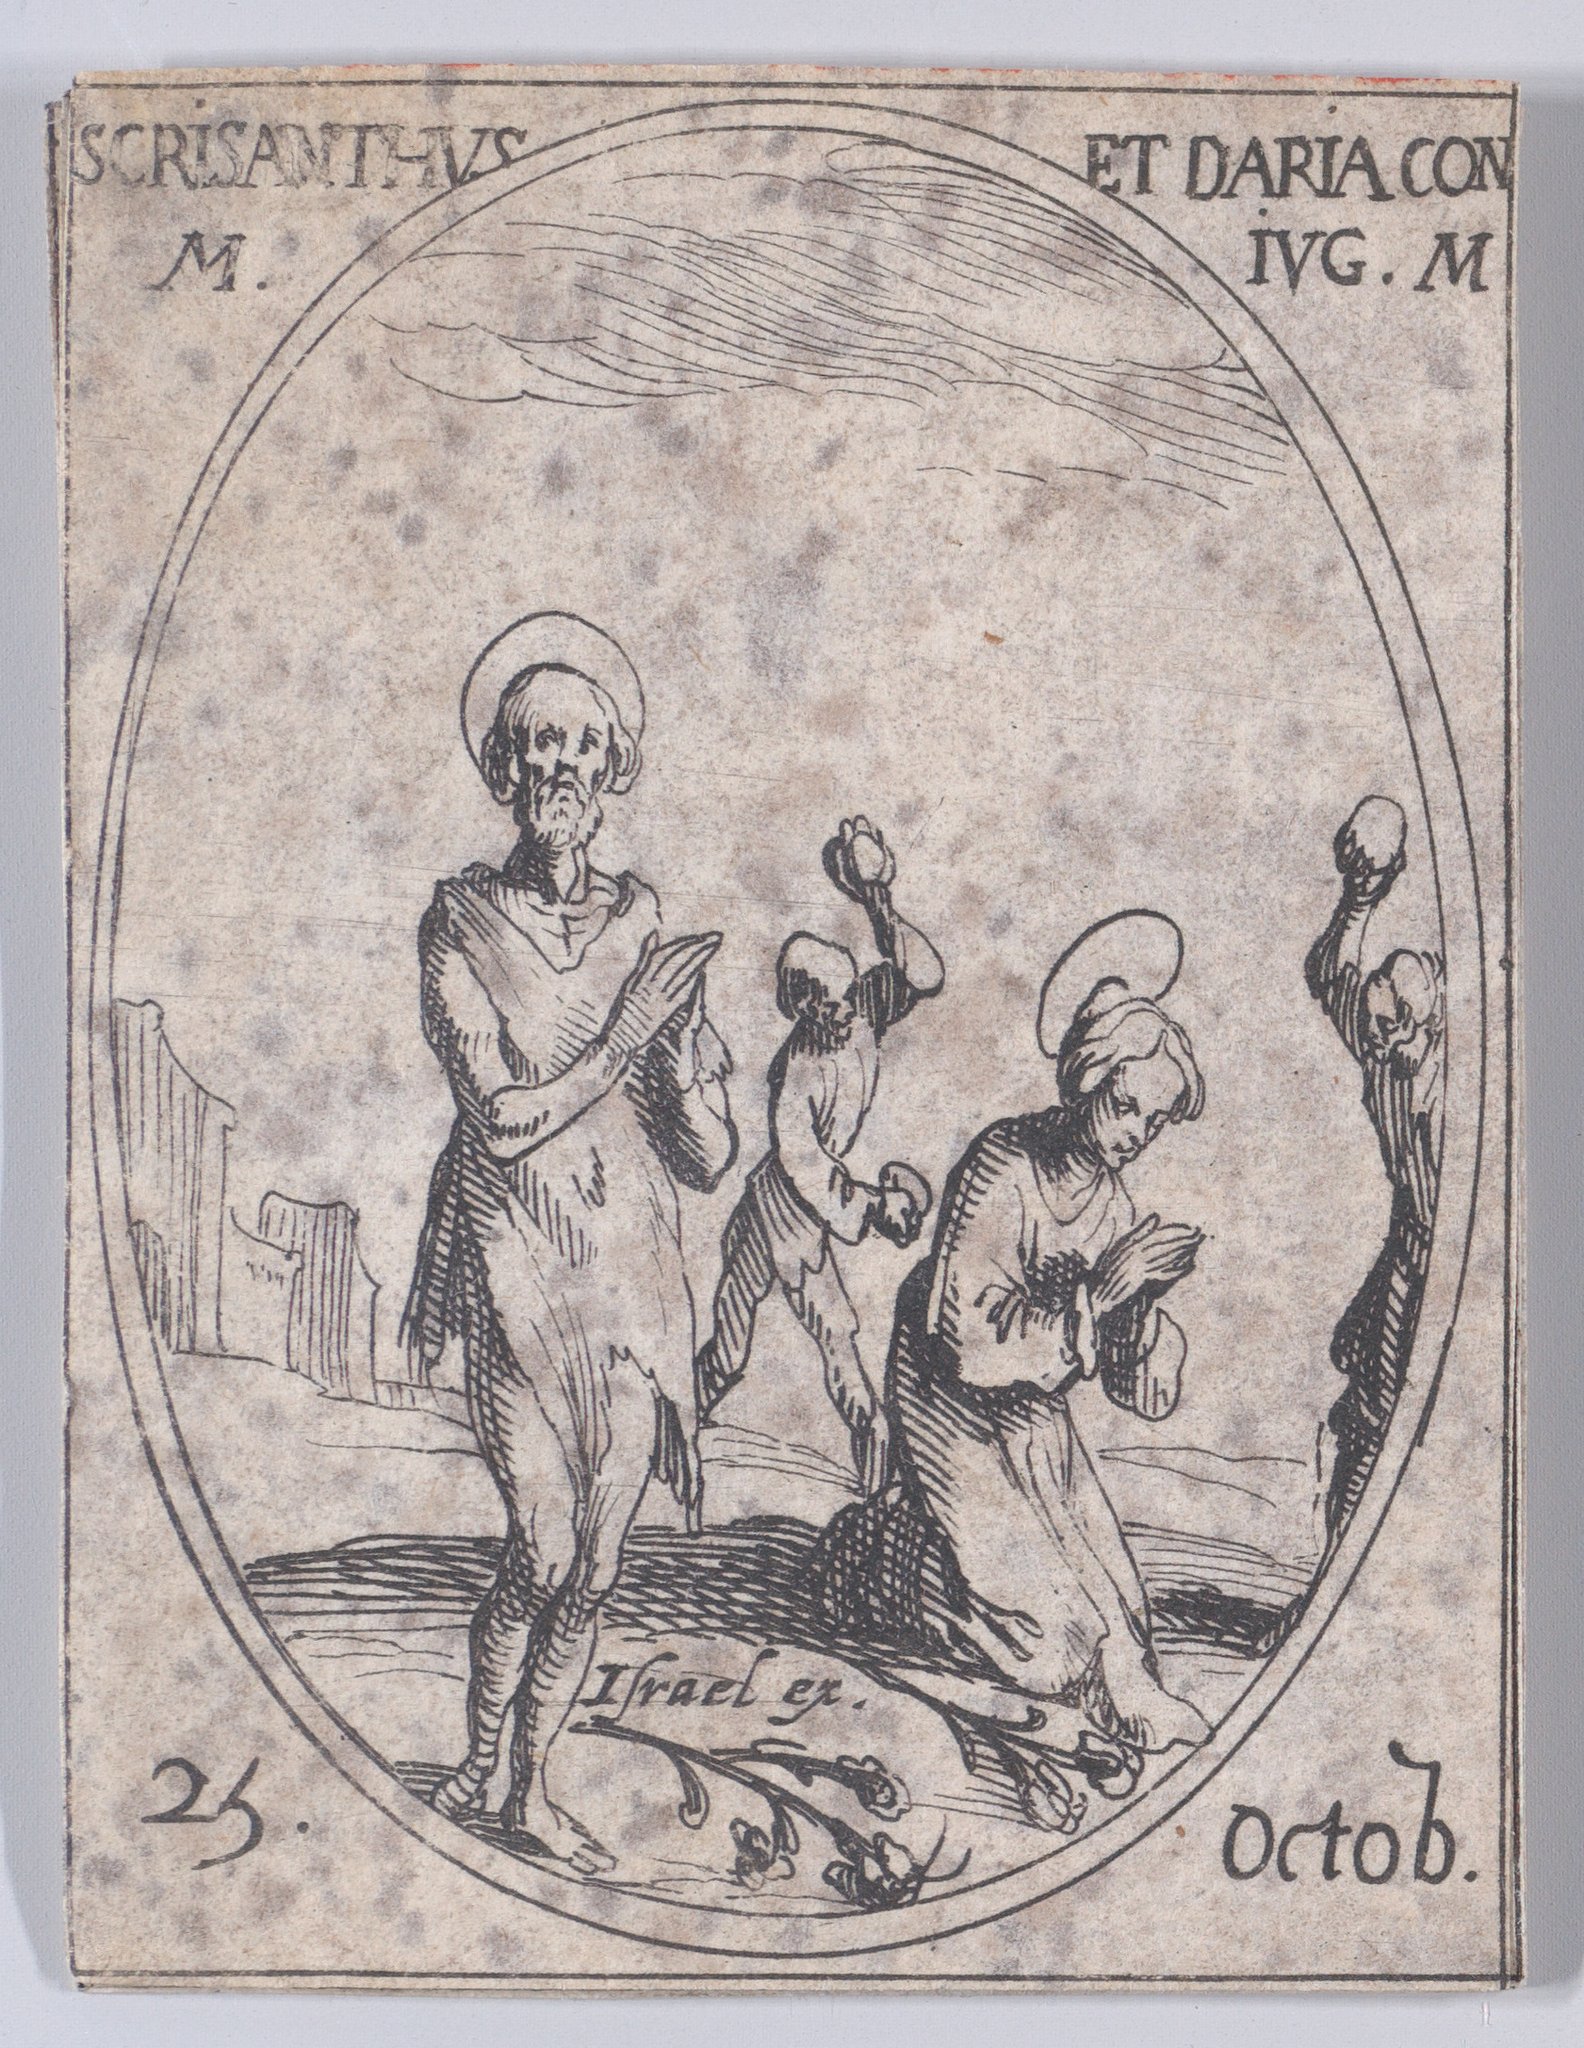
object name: print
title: S. Chrisante et Ste. Darie, Sa Femme (St. Chrysanthus and St. Daria, His Wife), October 25th, from "Les Images De Tous Les Saincts et Saintes de L'Année" (Images of All of the Saints and Religious Events of the Year)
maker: jacques callot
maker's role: artist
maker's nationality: french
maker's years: 1592-1635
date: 1636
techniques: etching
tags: men,women,saints